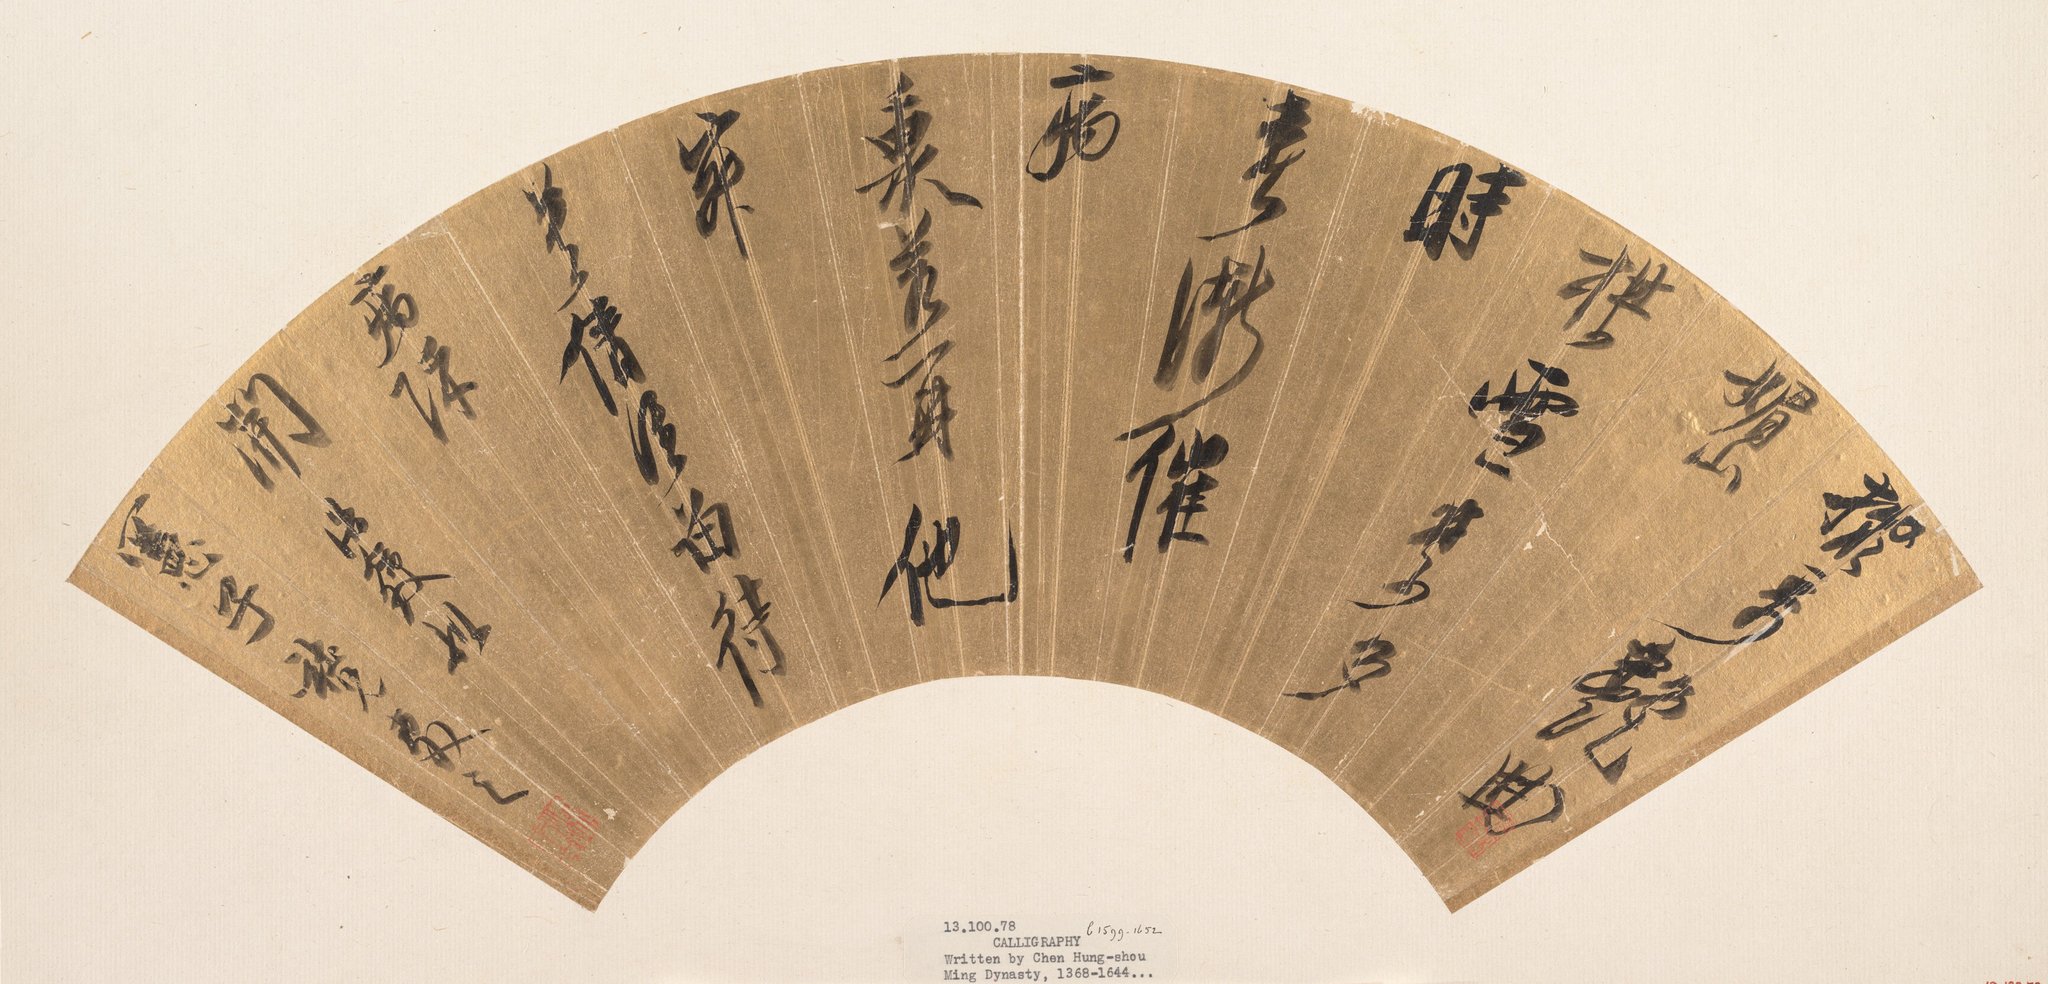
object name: folding fan mounted a an album leaf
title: Calligraphy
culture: chinese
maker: unidentified artist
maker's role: artist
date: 1368-1911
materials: ink, paper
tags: calligraphy